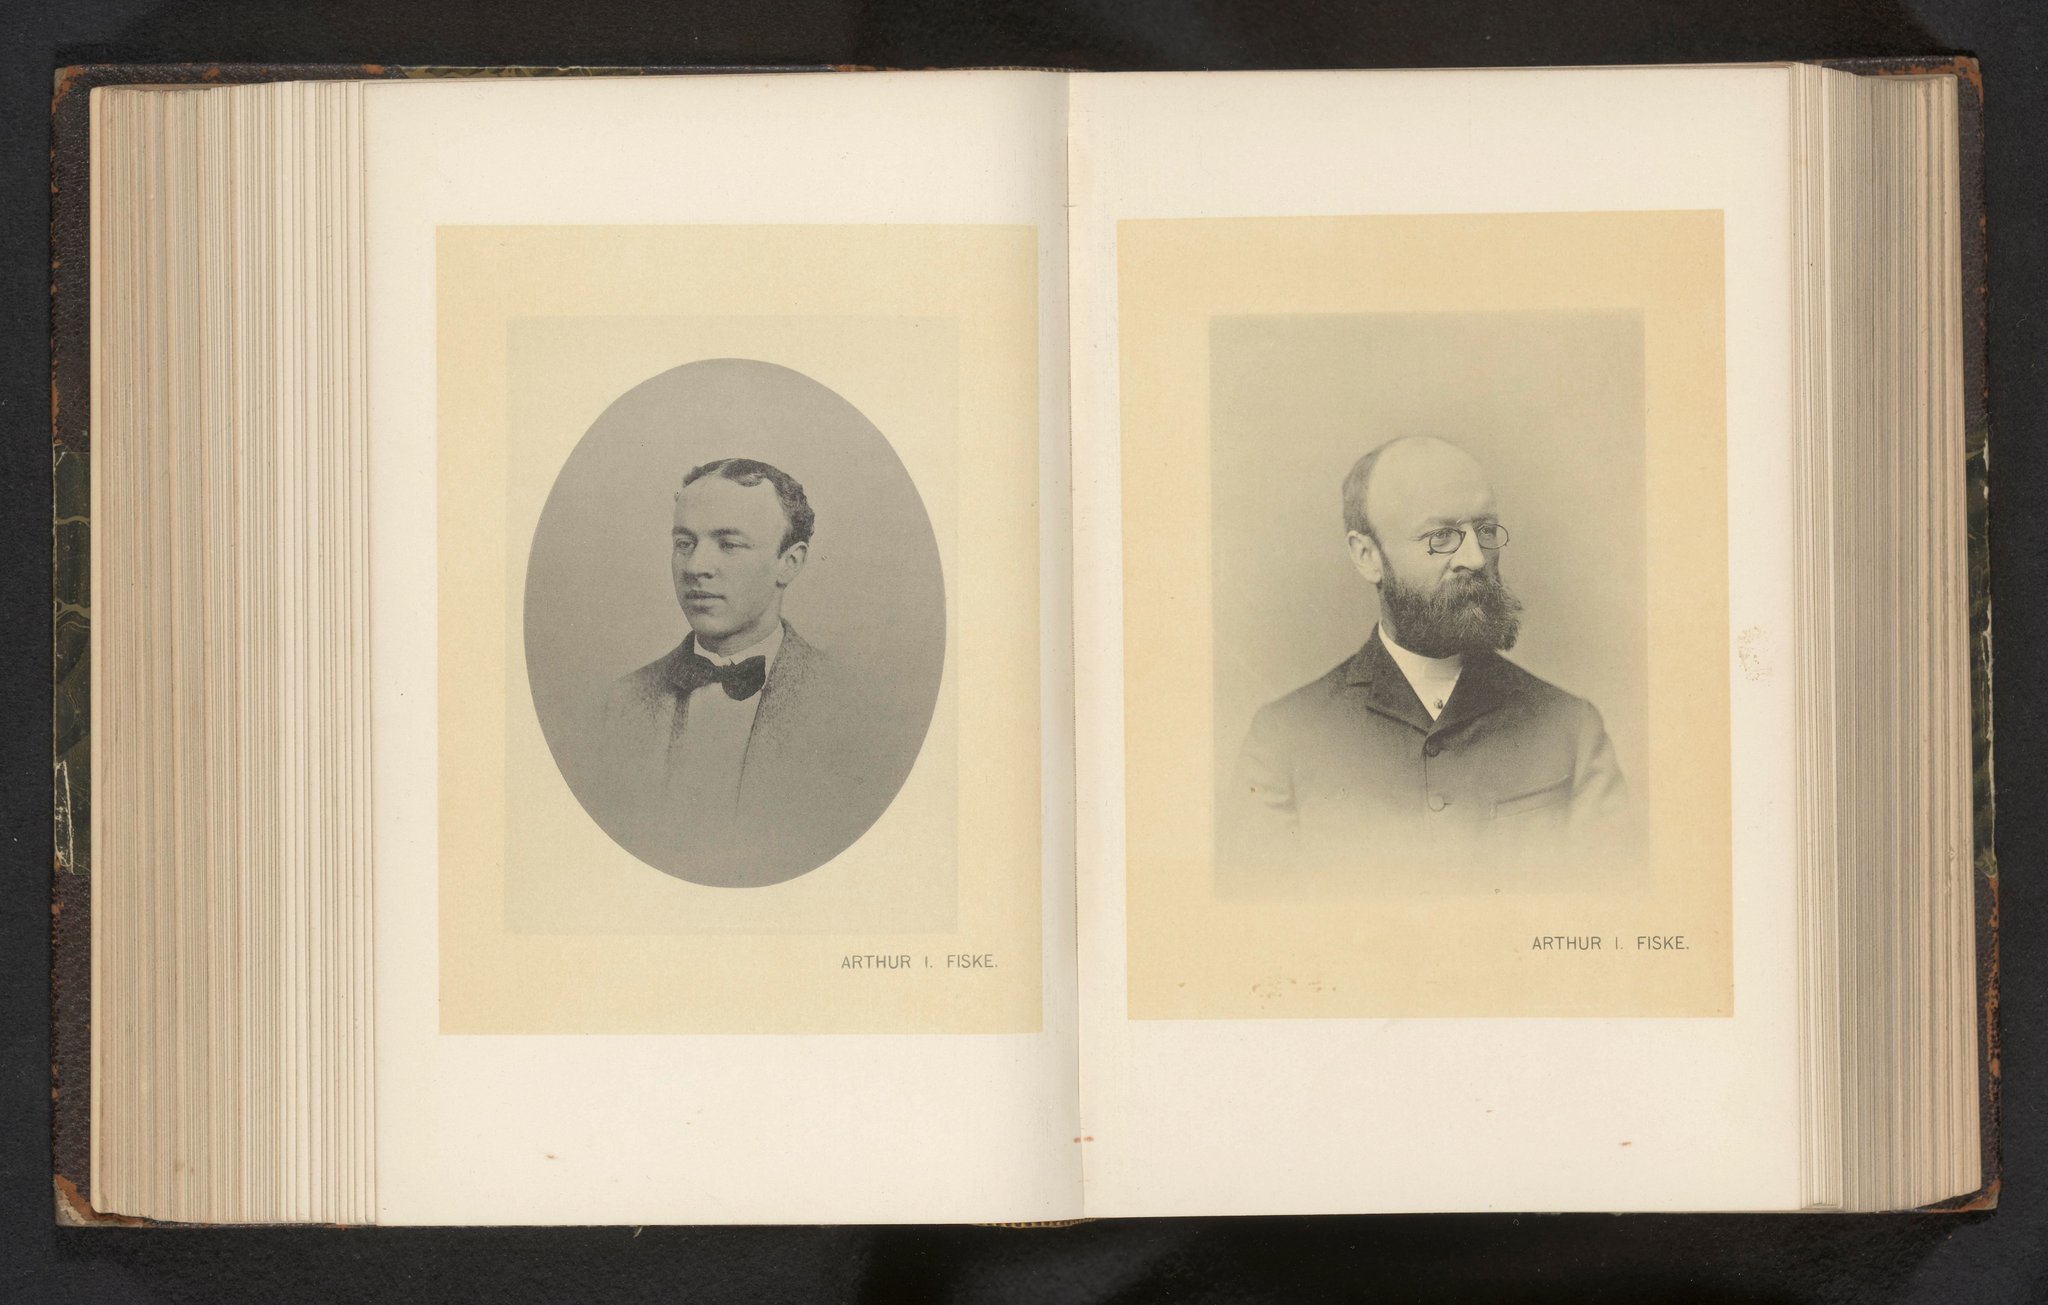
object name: page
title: Arthur I. Fiske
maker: Anonymous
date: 1889-1894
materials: paper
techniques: photoaquatint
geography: boston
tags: adult man